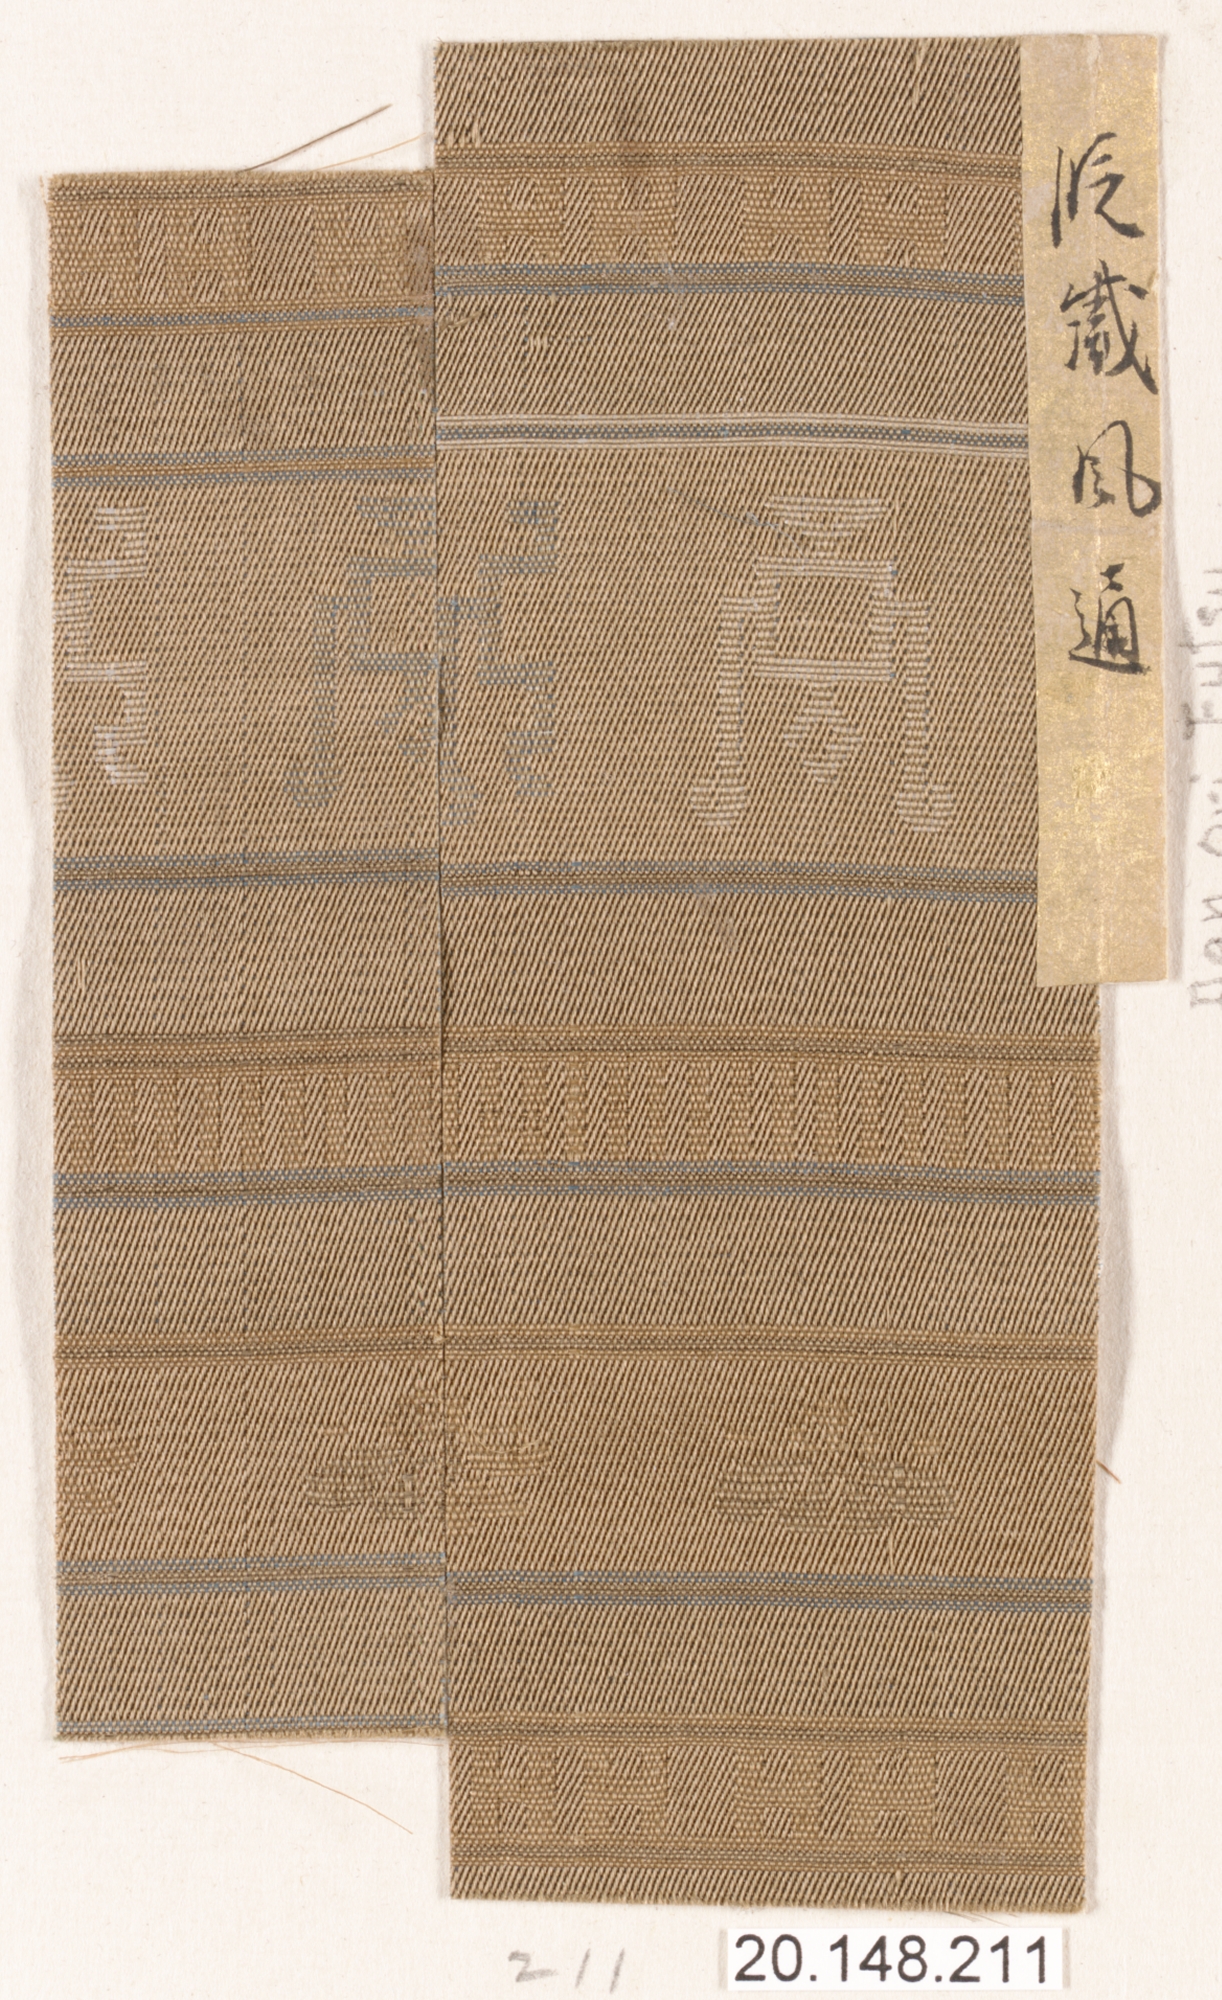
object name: piece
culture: japanese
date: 1701-1800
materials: silk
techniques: compound weave